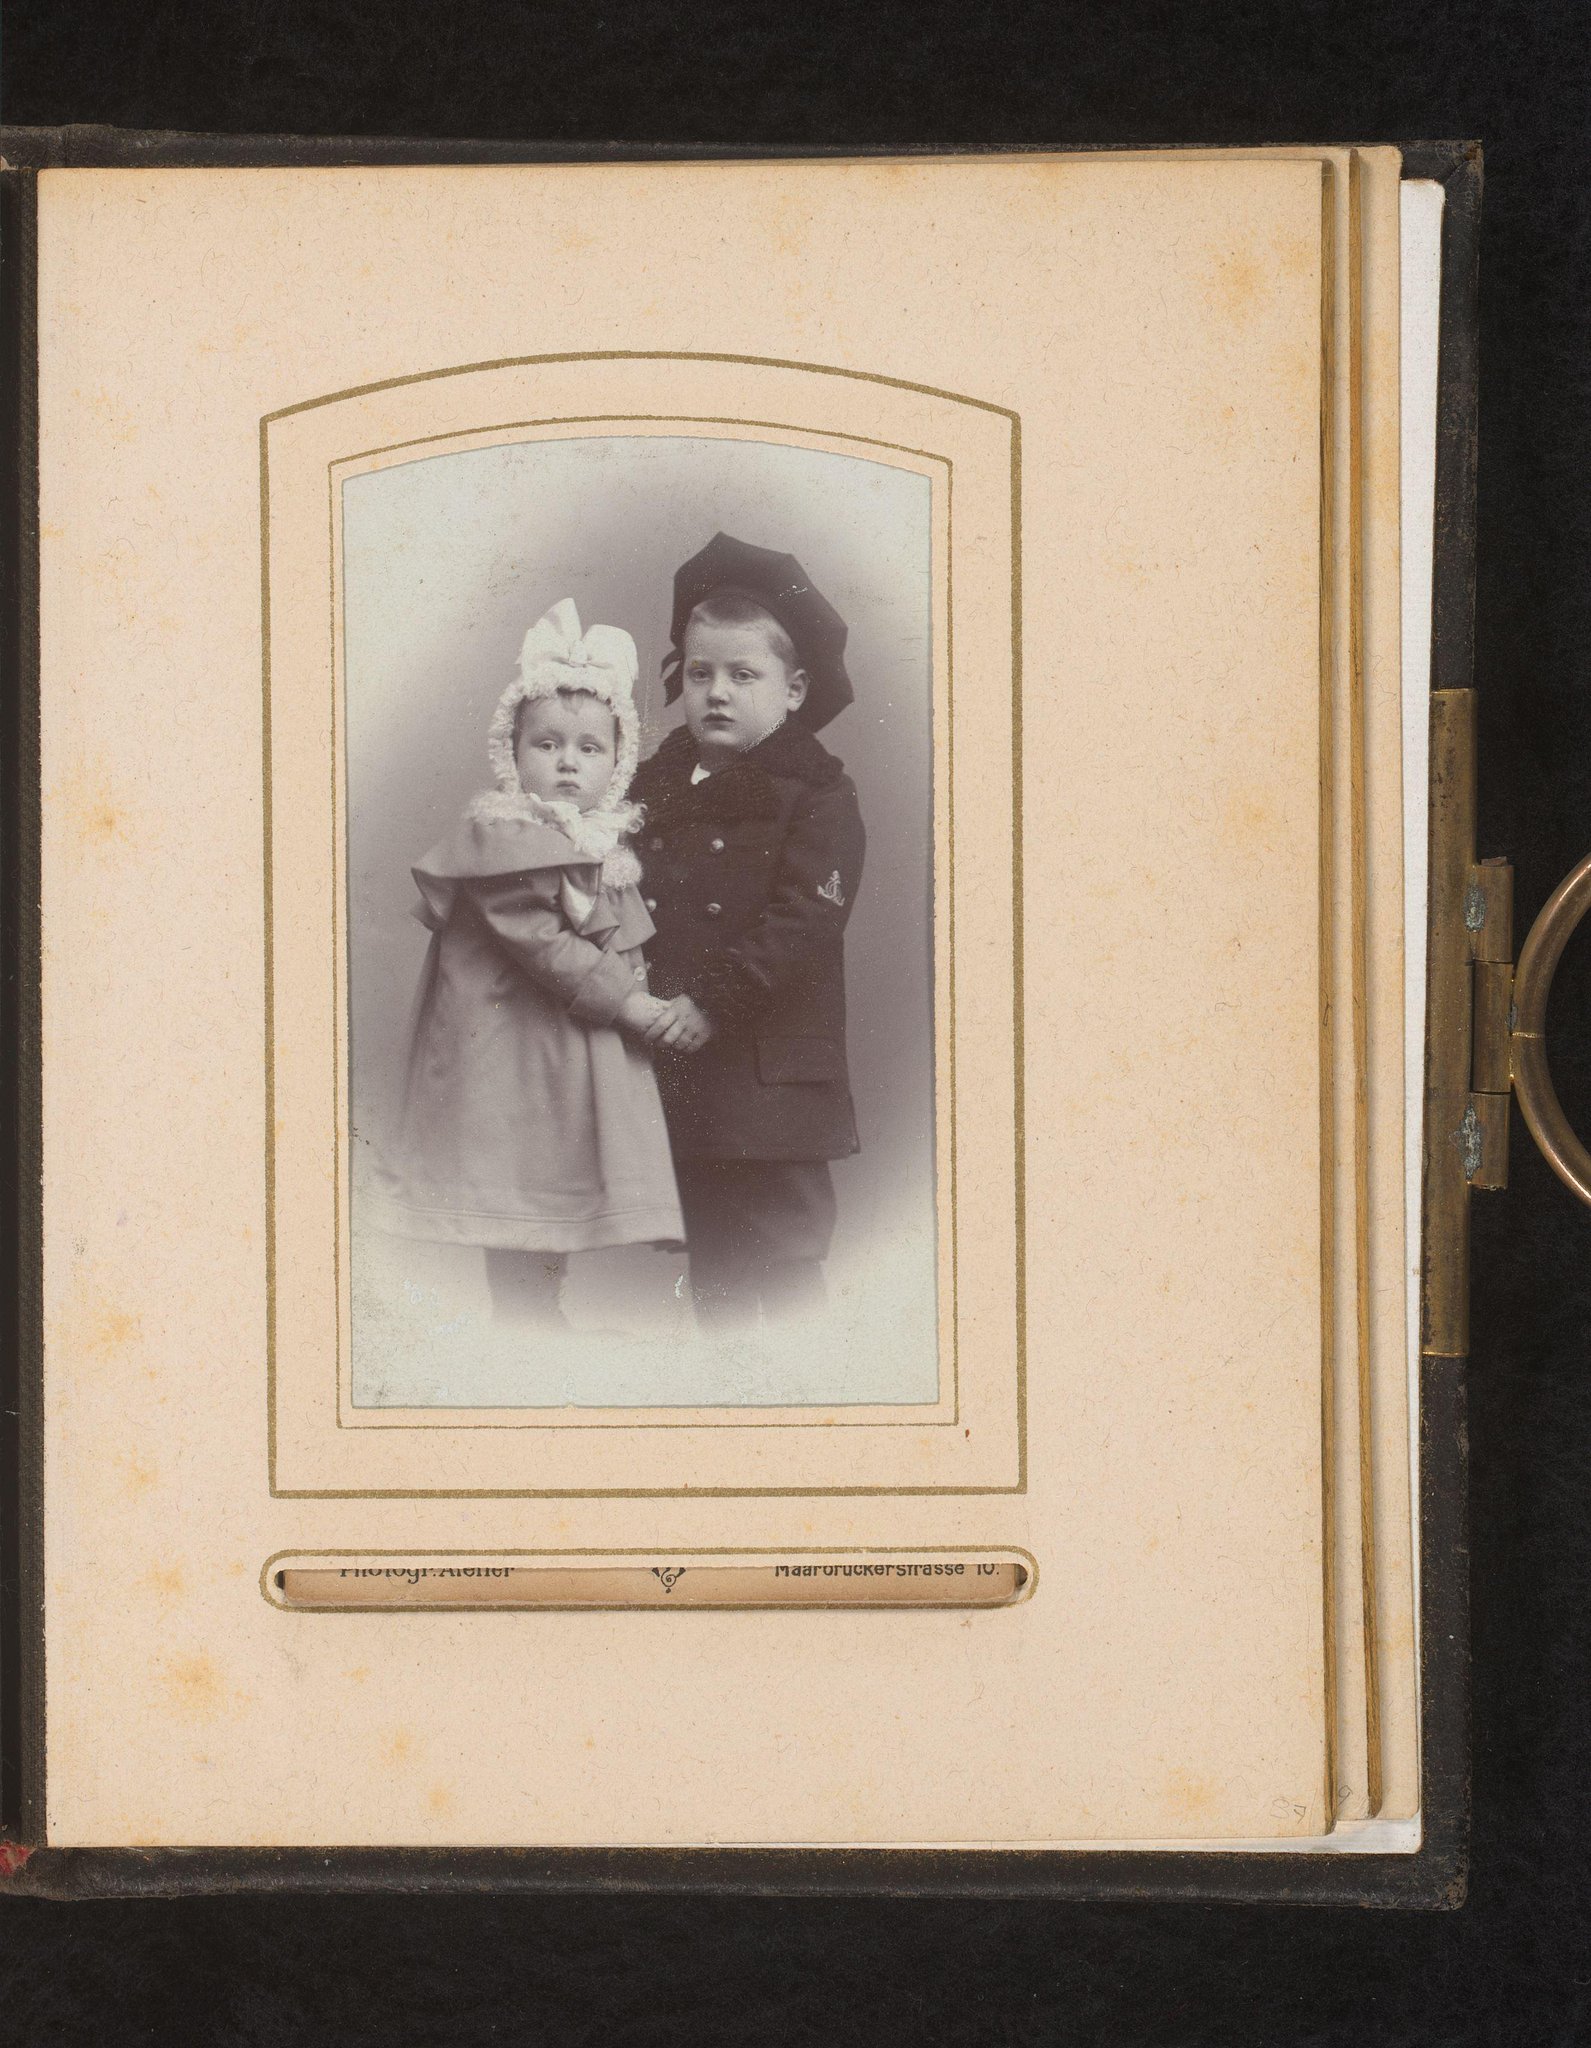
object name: carte de visite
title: Portret van een jongen en meisje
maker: albert hoffmann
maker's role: fotograaf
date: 1880-1910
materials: cardboard, photographic support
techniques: collodion silver print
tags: child, historical persons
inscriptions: inscription: ‘Photographisches/ Atelier/ (...)/ Albert Hoffmann/ Bochum/ i/w./ Maarbrückerstrasse 10./ (...)’